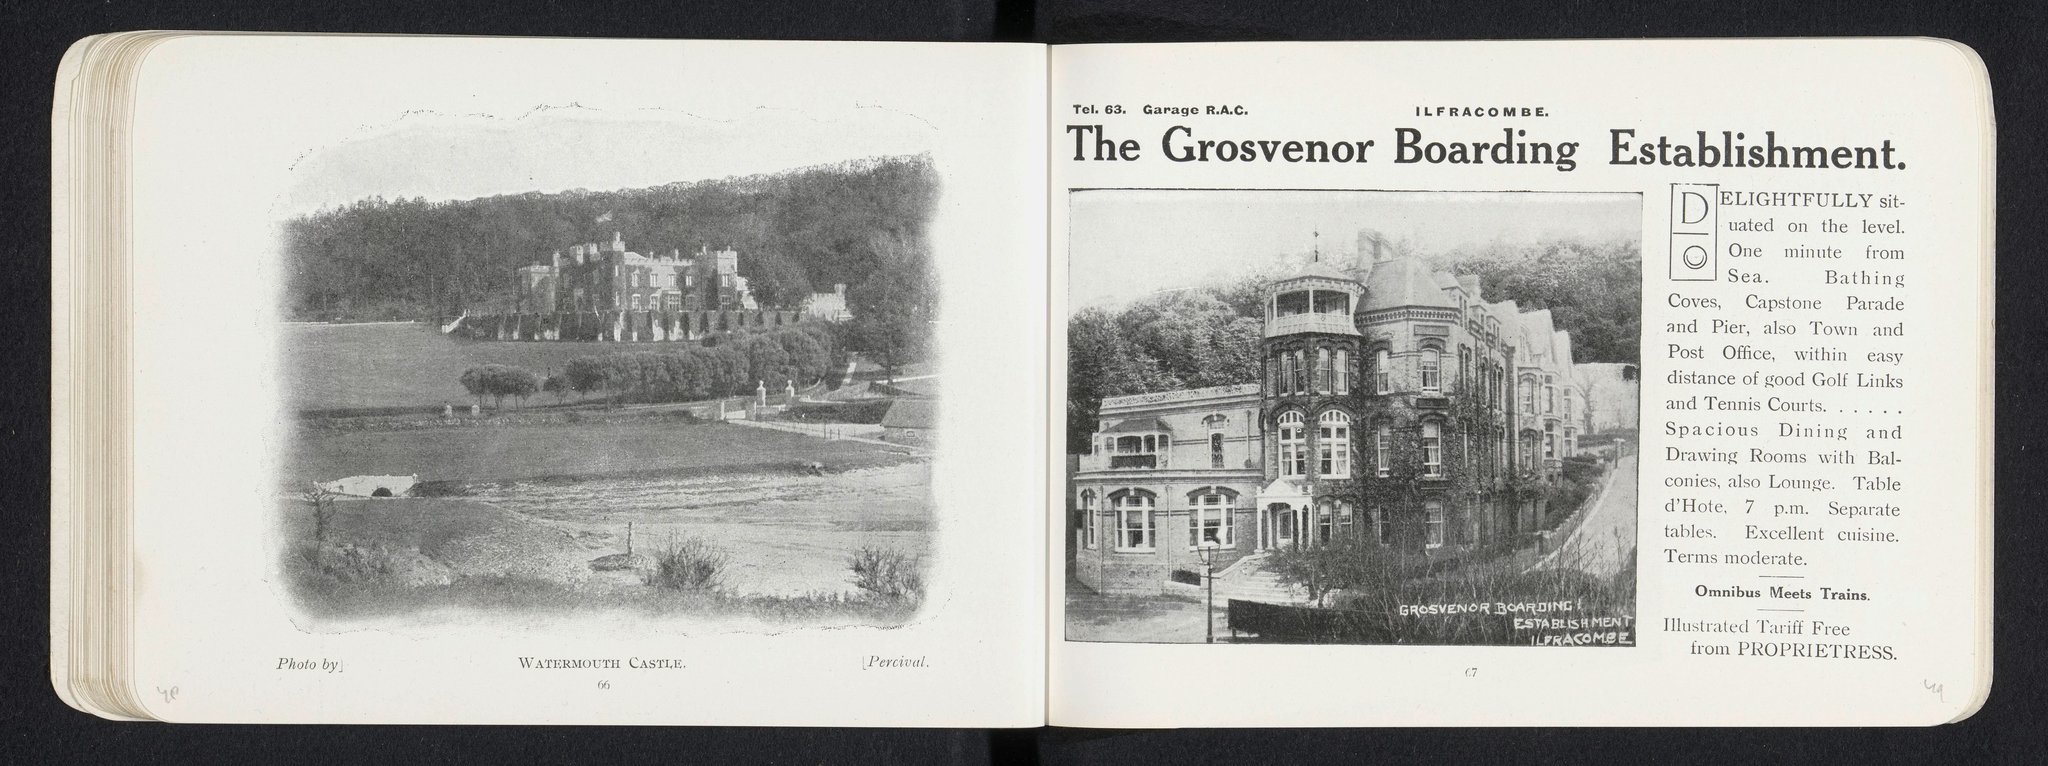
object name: page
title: Gevel van het Grosvenor Hotel te Ilfracombe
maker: Anonymous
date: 1900-1920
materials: paper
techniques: autotype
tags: façade (of house or building), hotel, hostelry, inn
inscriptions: inscription: ‘The Grosvenor Boarding Establishment (...) from Proprietress.’